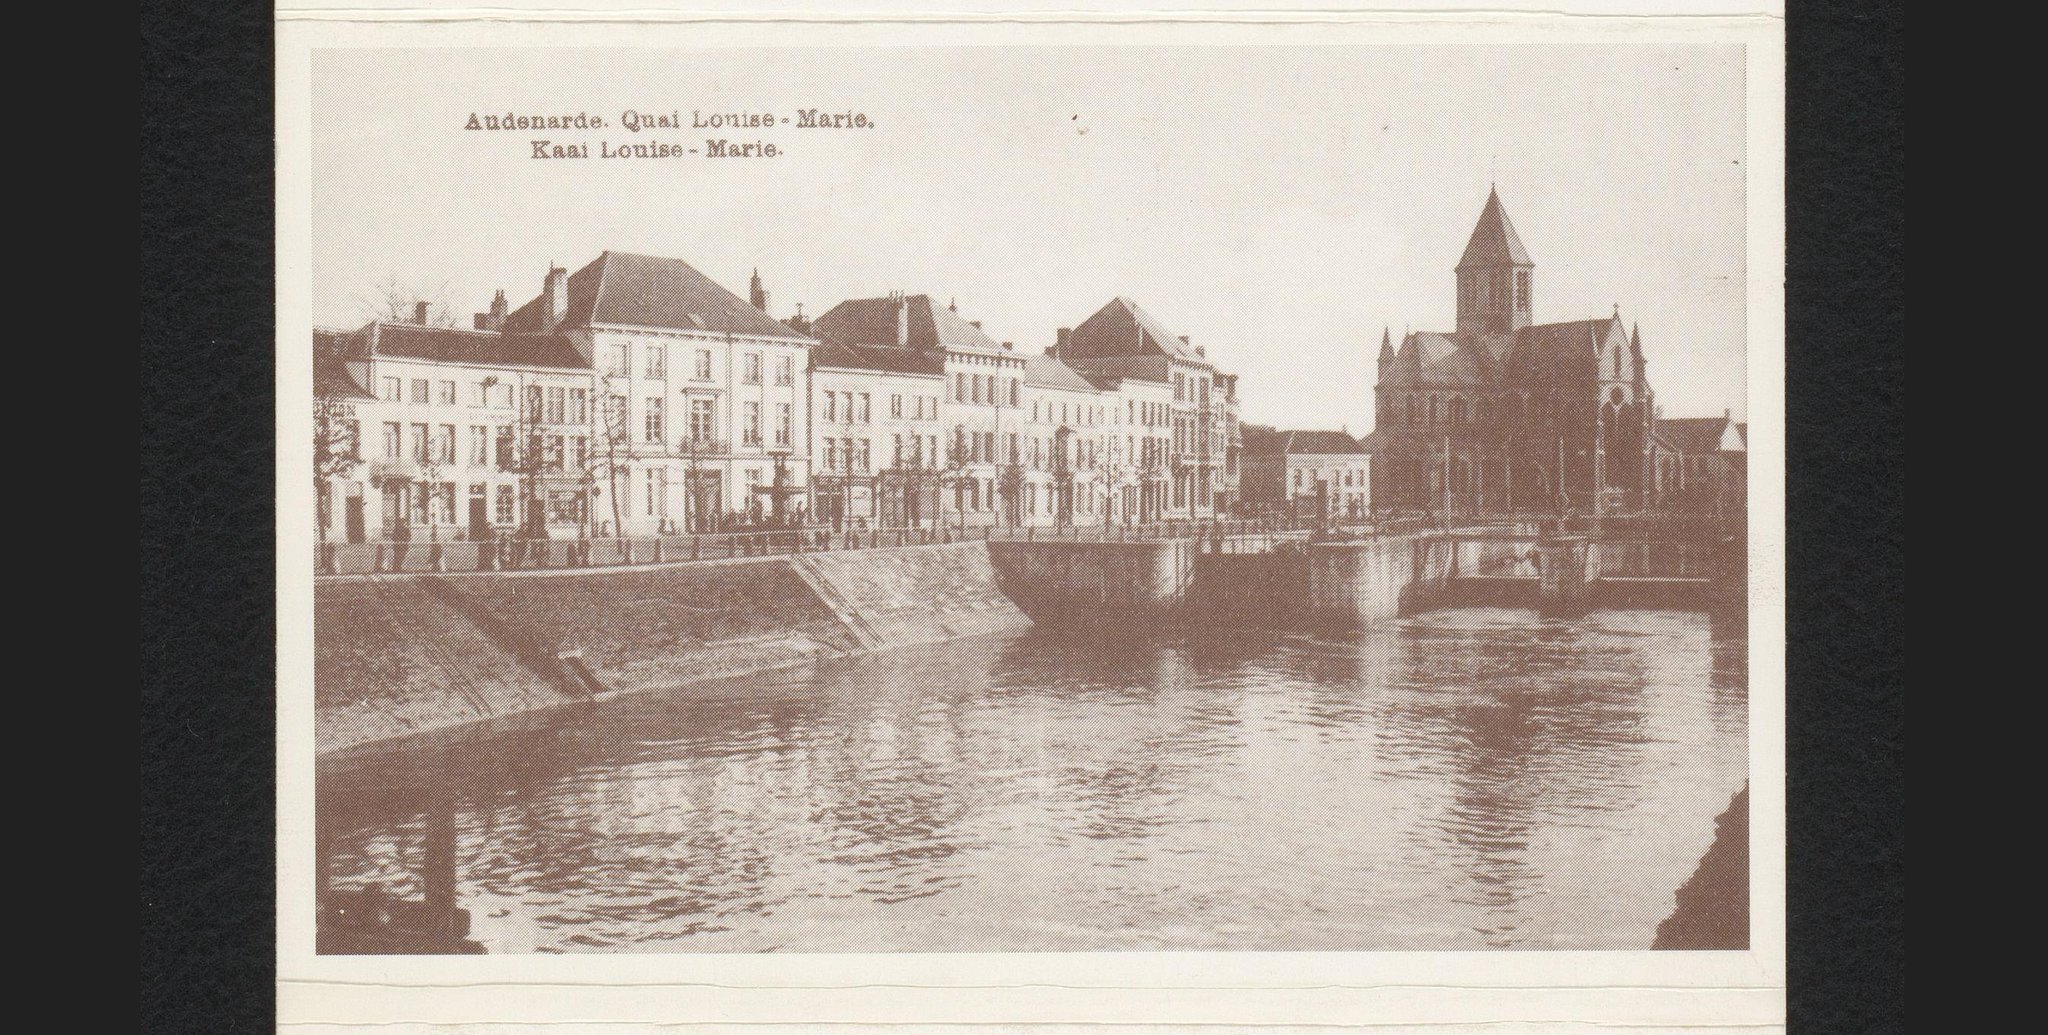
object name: reproduction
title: Audenarde. Quai Louise-Marie / Kaai Louise-Marie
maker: Anonymous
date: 1981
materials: cardboard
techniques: offset printed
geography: oudenaarde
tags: church (exterior), quay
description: Deze prentbriefkaart is een reproductie van een oudere prentbriefkaart.